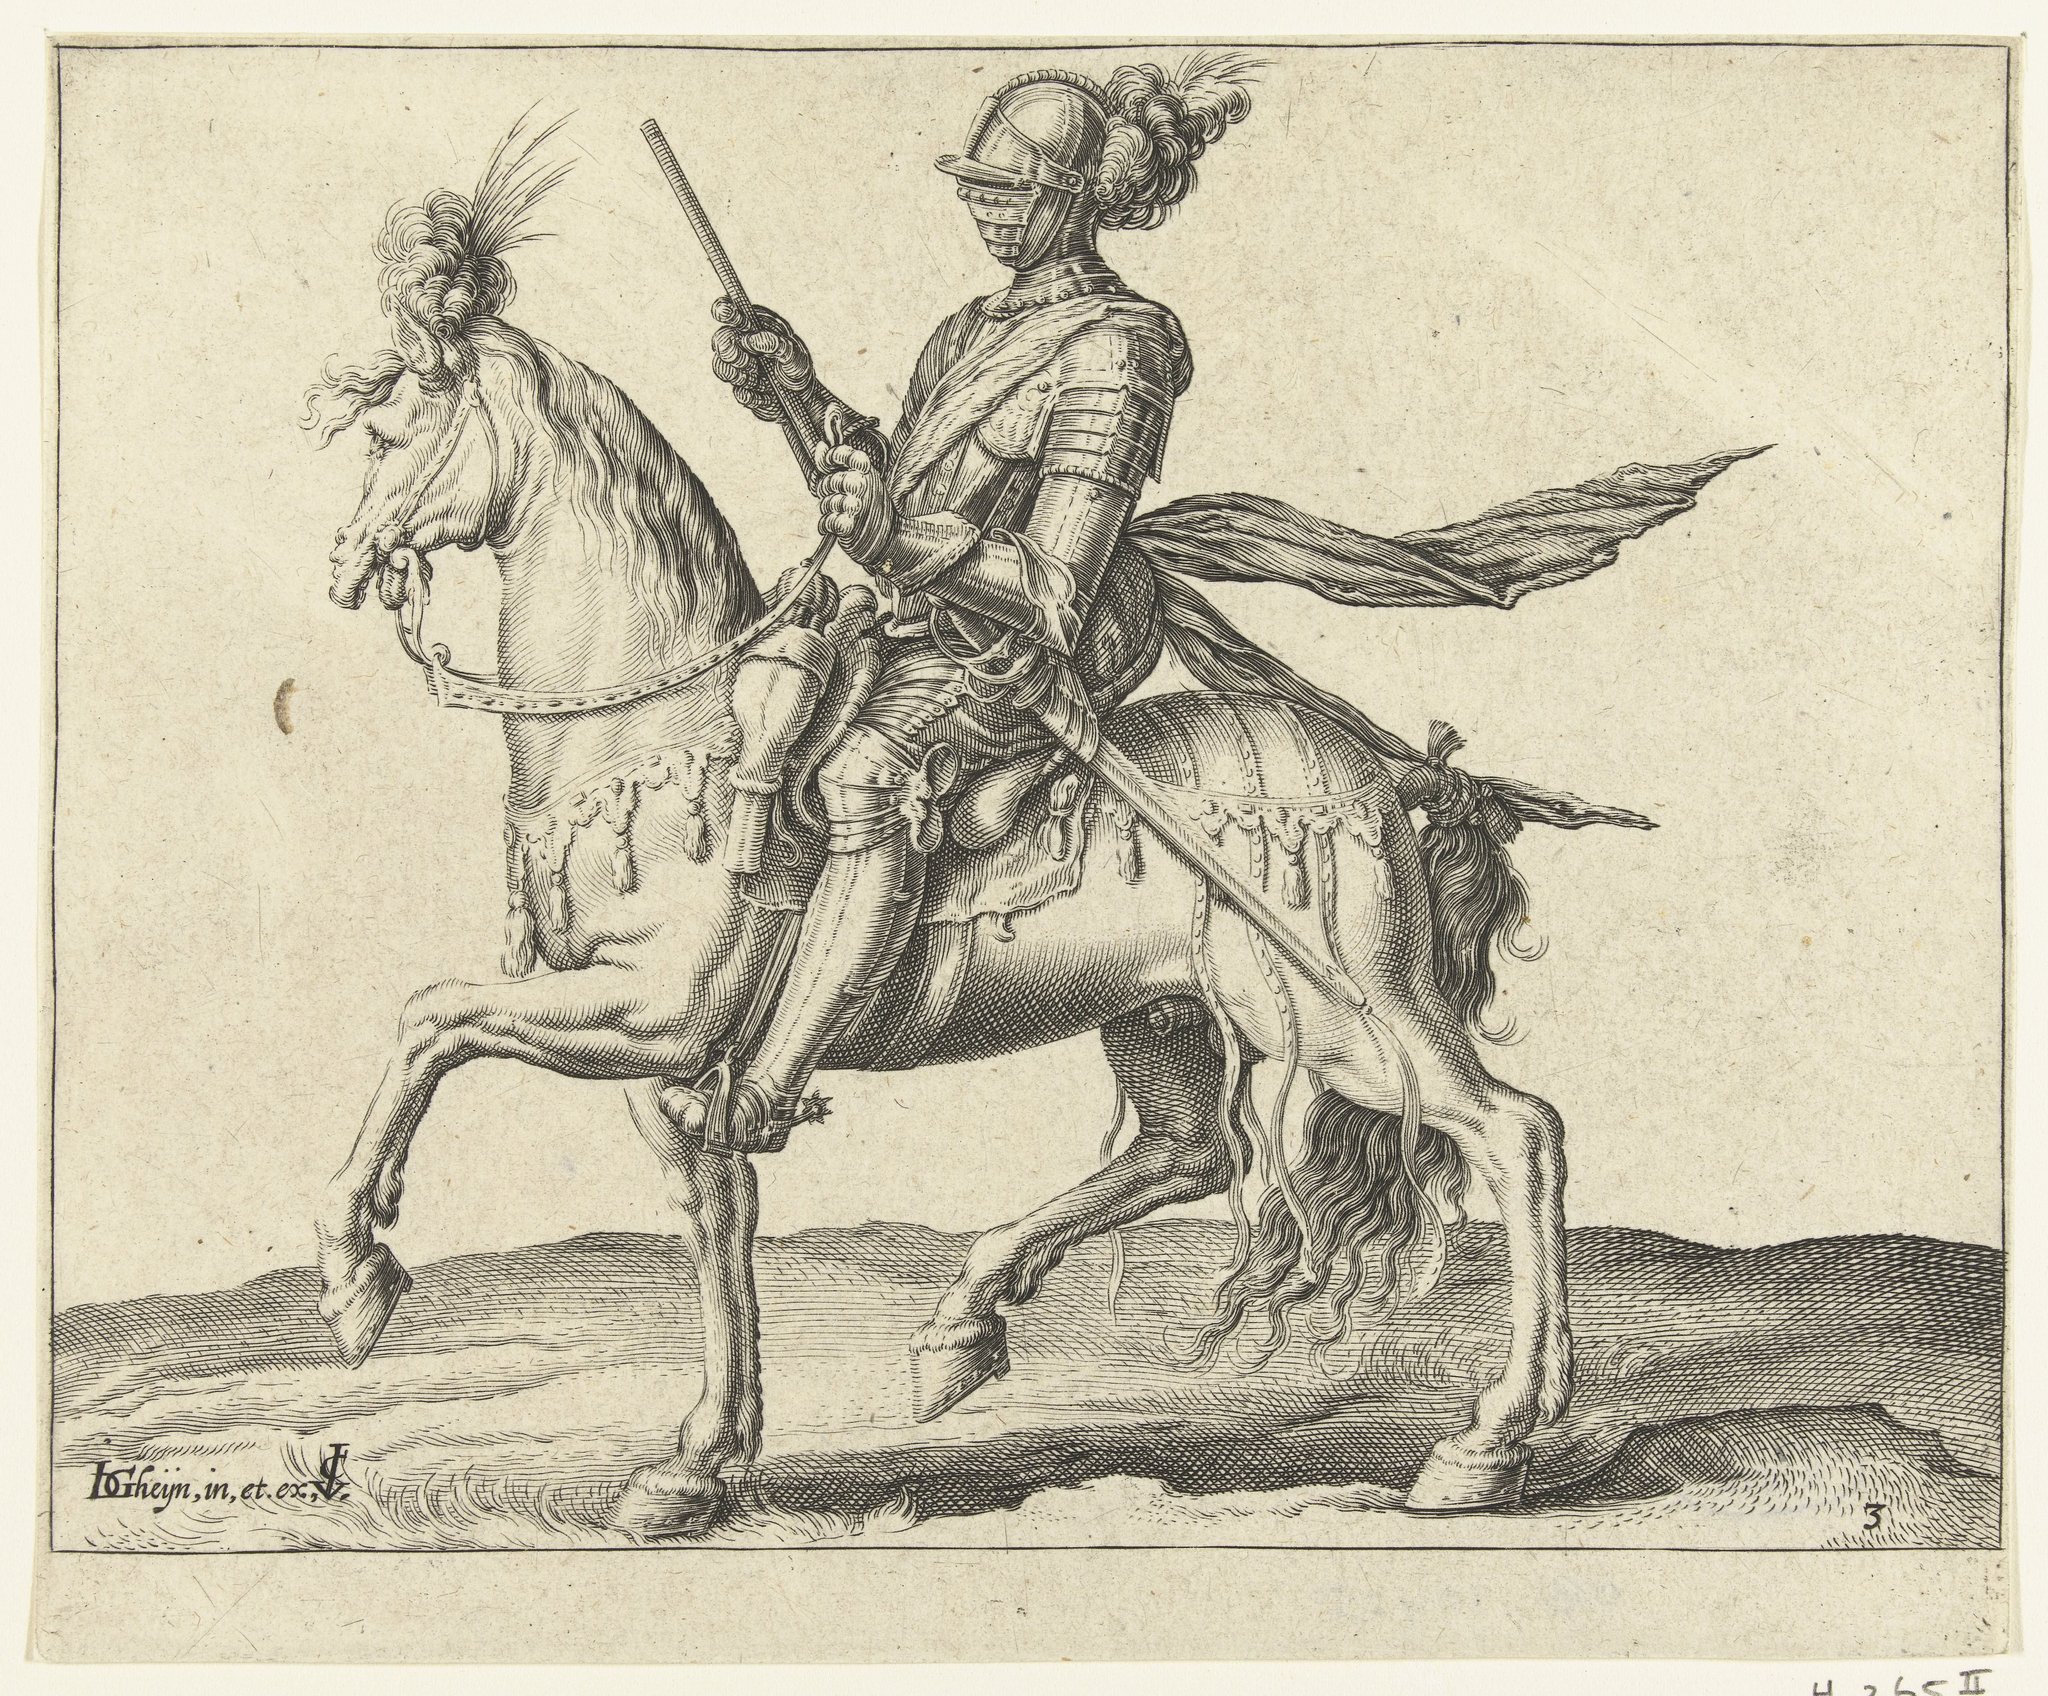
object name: print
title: De ruiterschool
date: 1599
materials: paper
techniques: engraving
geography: amsterdam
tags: warfare; military affairs (+ cavalry, horsemen), officer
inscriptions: collector's mark: Lugt 2228a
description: Een geharnaste man te paard, naar links rijdend, met een aanvoerdersstaf in de rechterhand (een ritmeester). Deze prent is onderdeel van een serie van 22 genummerde prenten: een titelprent, 20 prenten waarop één of enkele verschillende typen (meest geharnaste) ruiters zijn weergegeven, en een prent met een ruitergevecht.